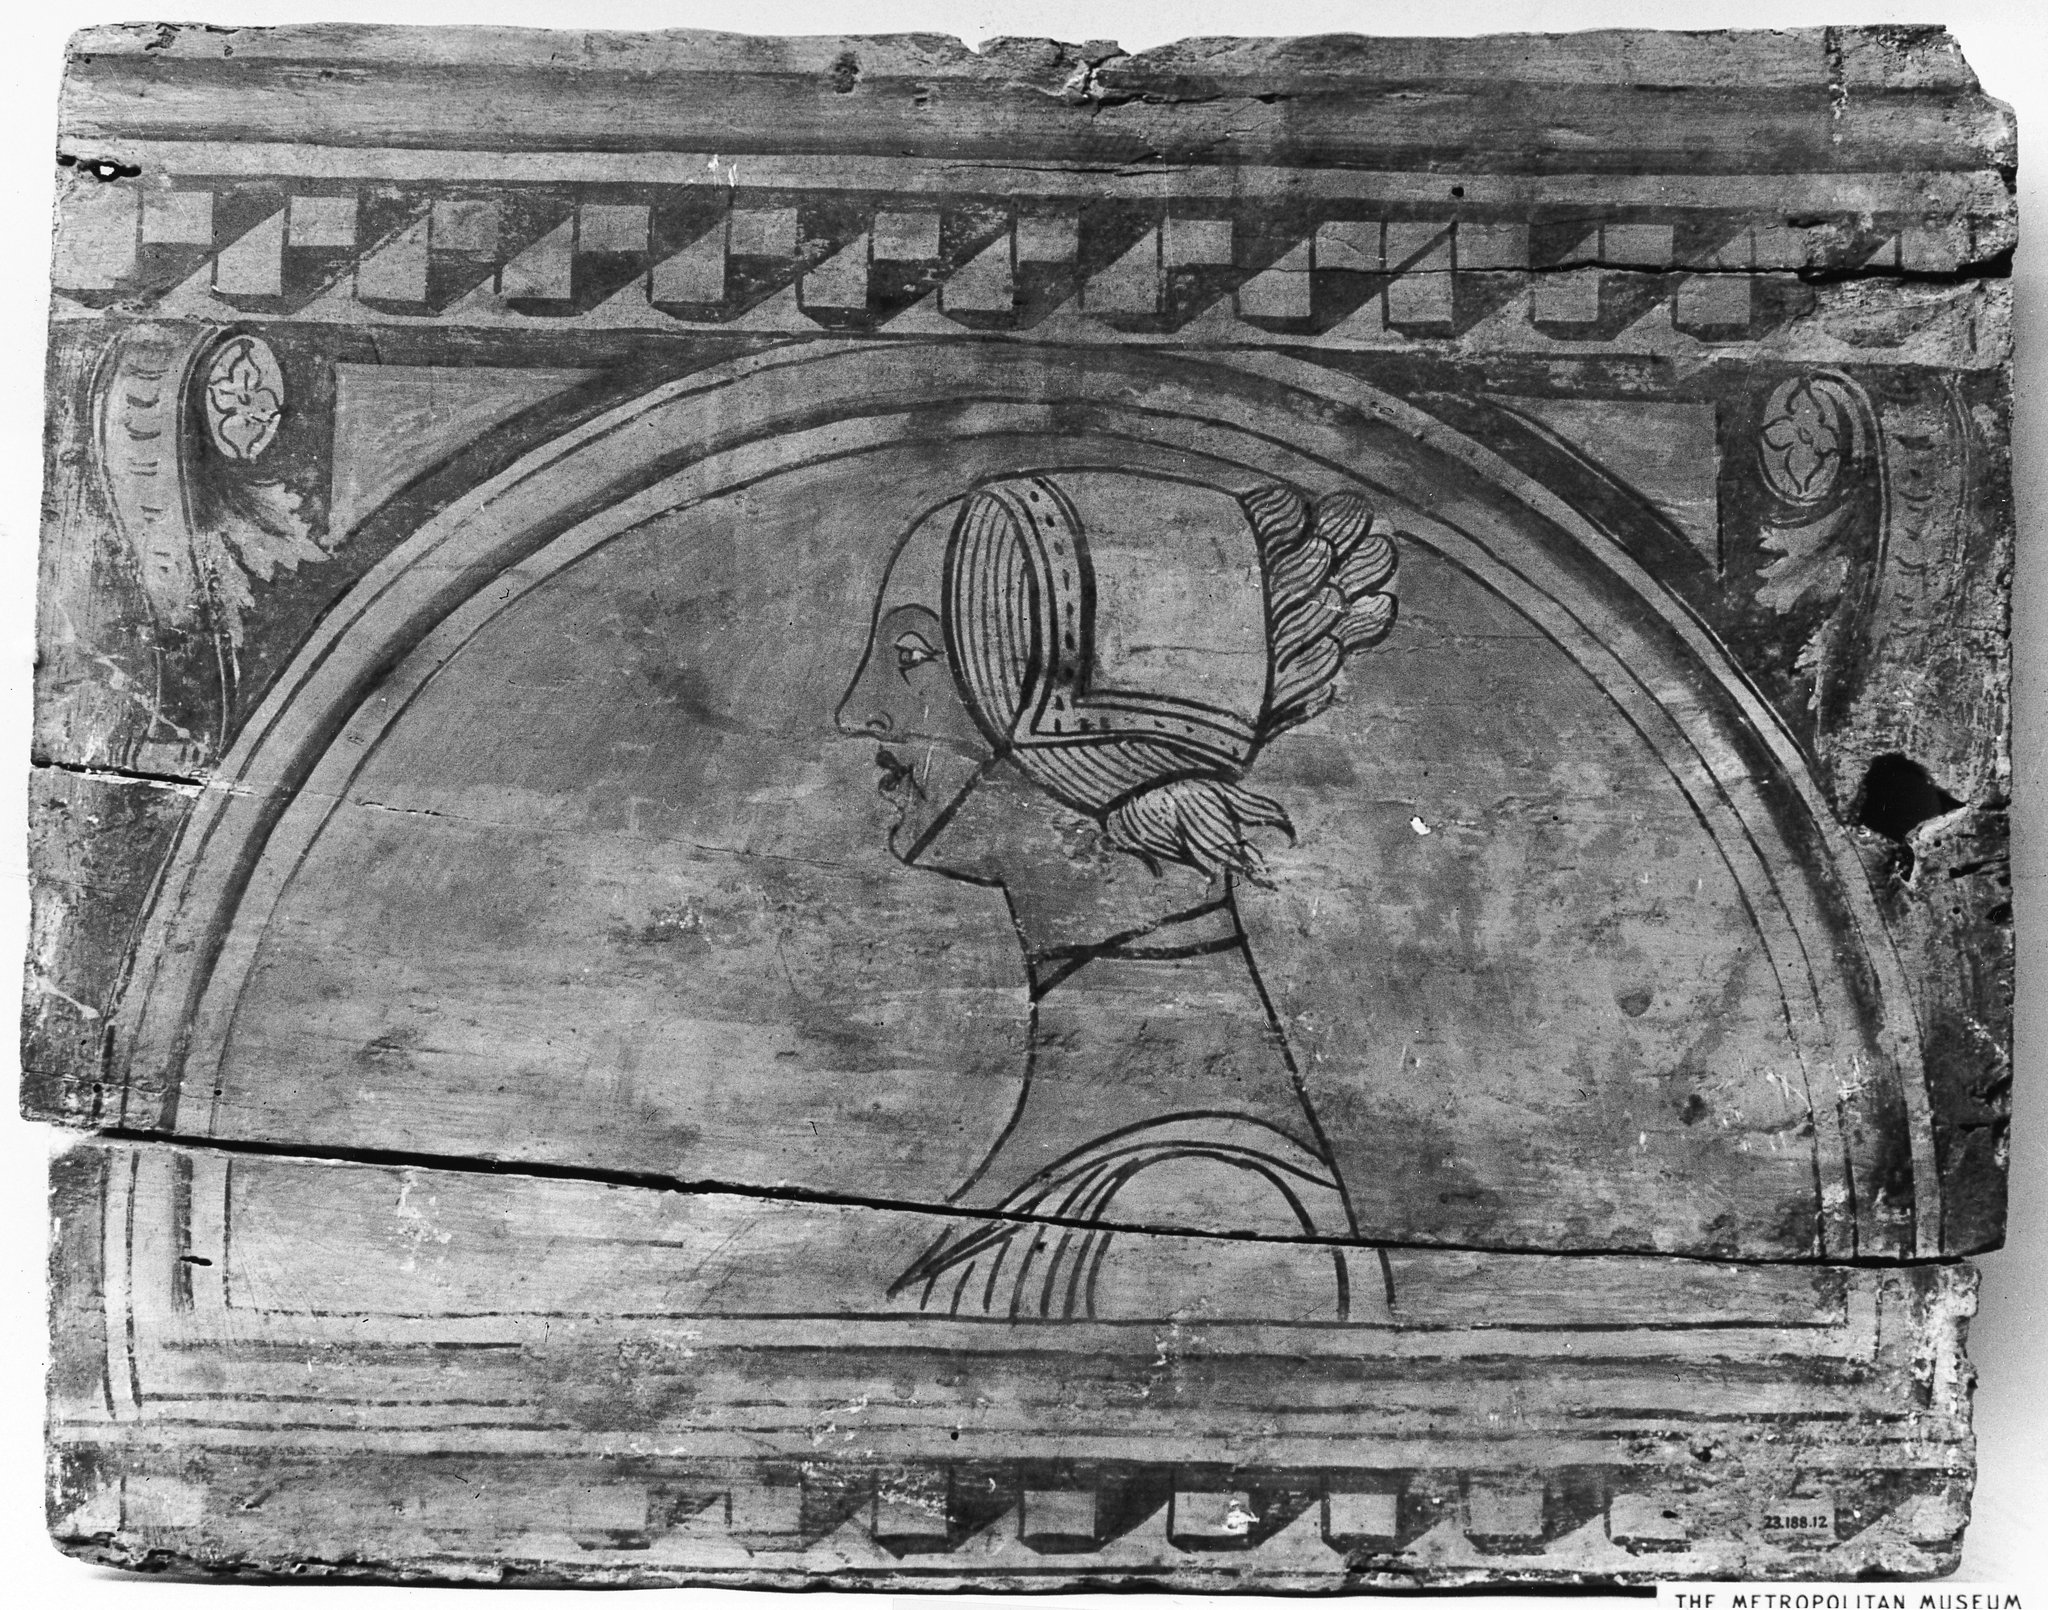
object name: frieze panel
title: Head of a woman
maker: north italian painter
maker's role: artist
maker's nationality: italian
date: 1467-1500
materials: paint, wood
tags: profiles,women